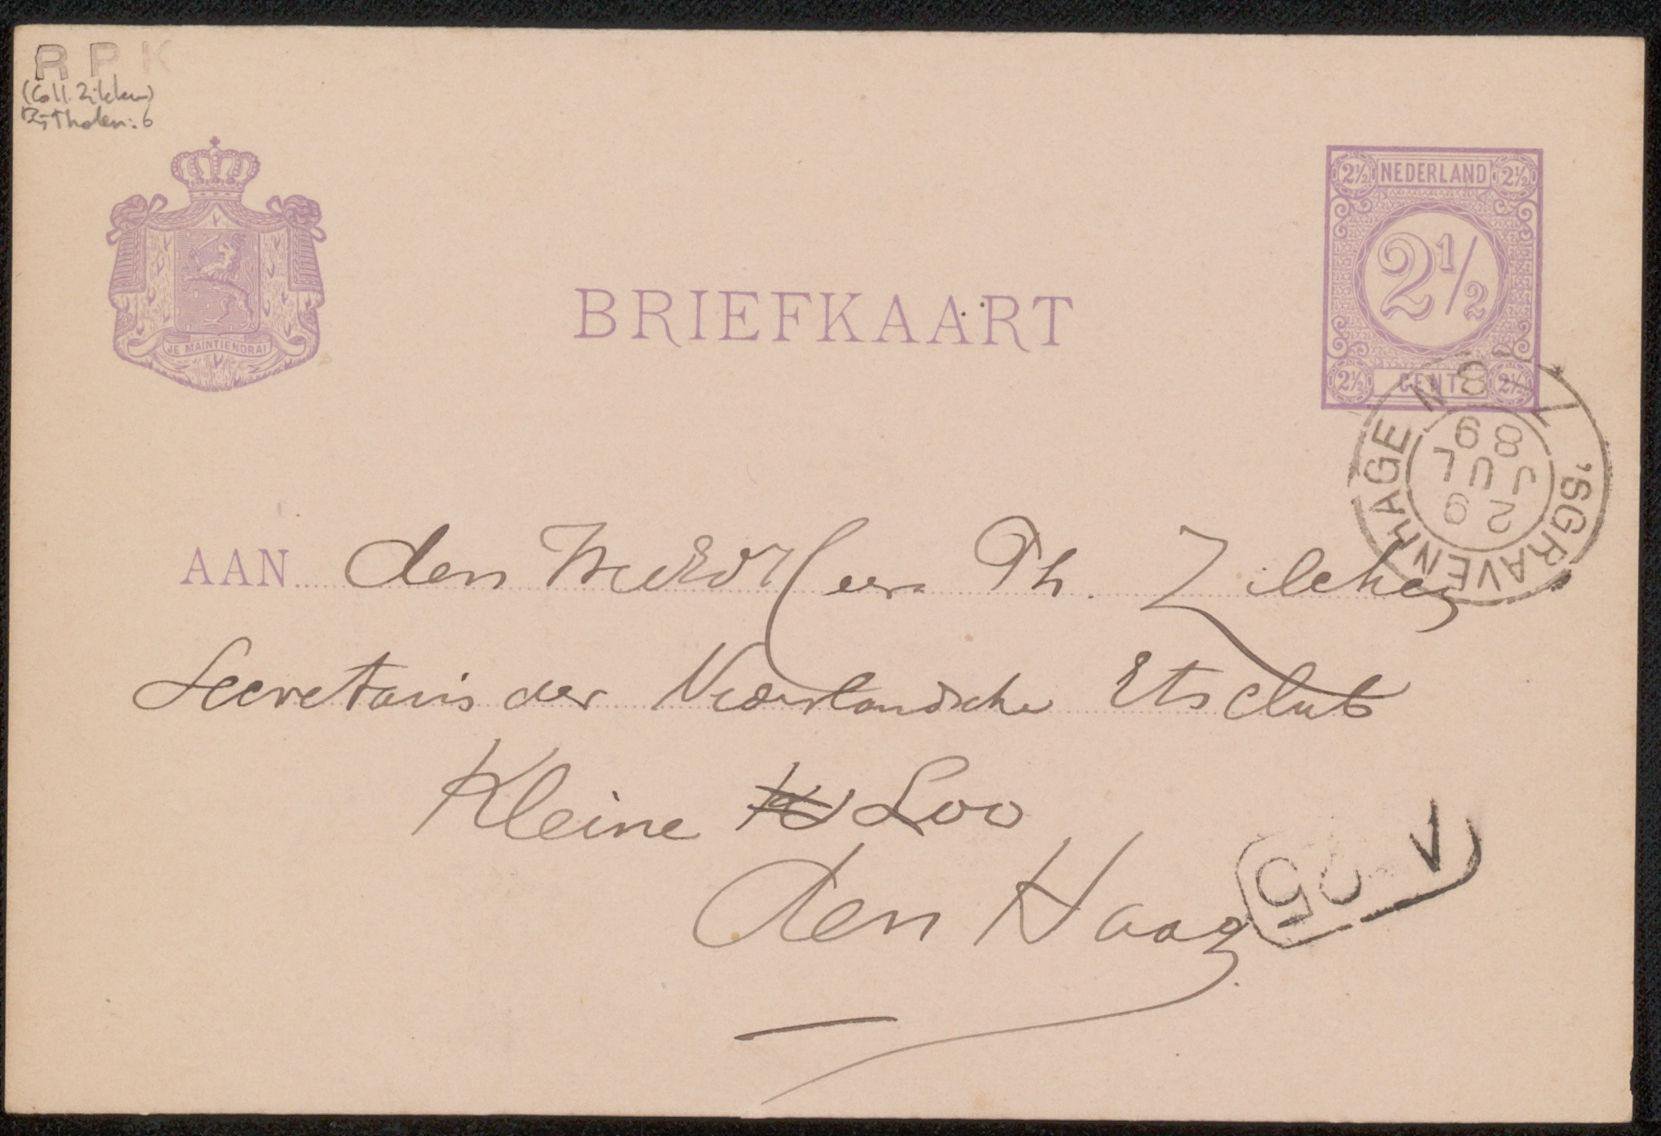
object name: postcard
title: Briefkaart aan Philip Zilcken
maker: willem bastiaan tholen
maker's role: draughtsman, painter, print maker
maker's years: 1860-1931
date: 1889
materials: cardboard, ink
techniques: pen, writing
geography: ewijkshoeve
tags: the hague, painter, draughtsman, philip zilcken, exhibition ~ art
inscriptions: collector's mark: ‘RPK’